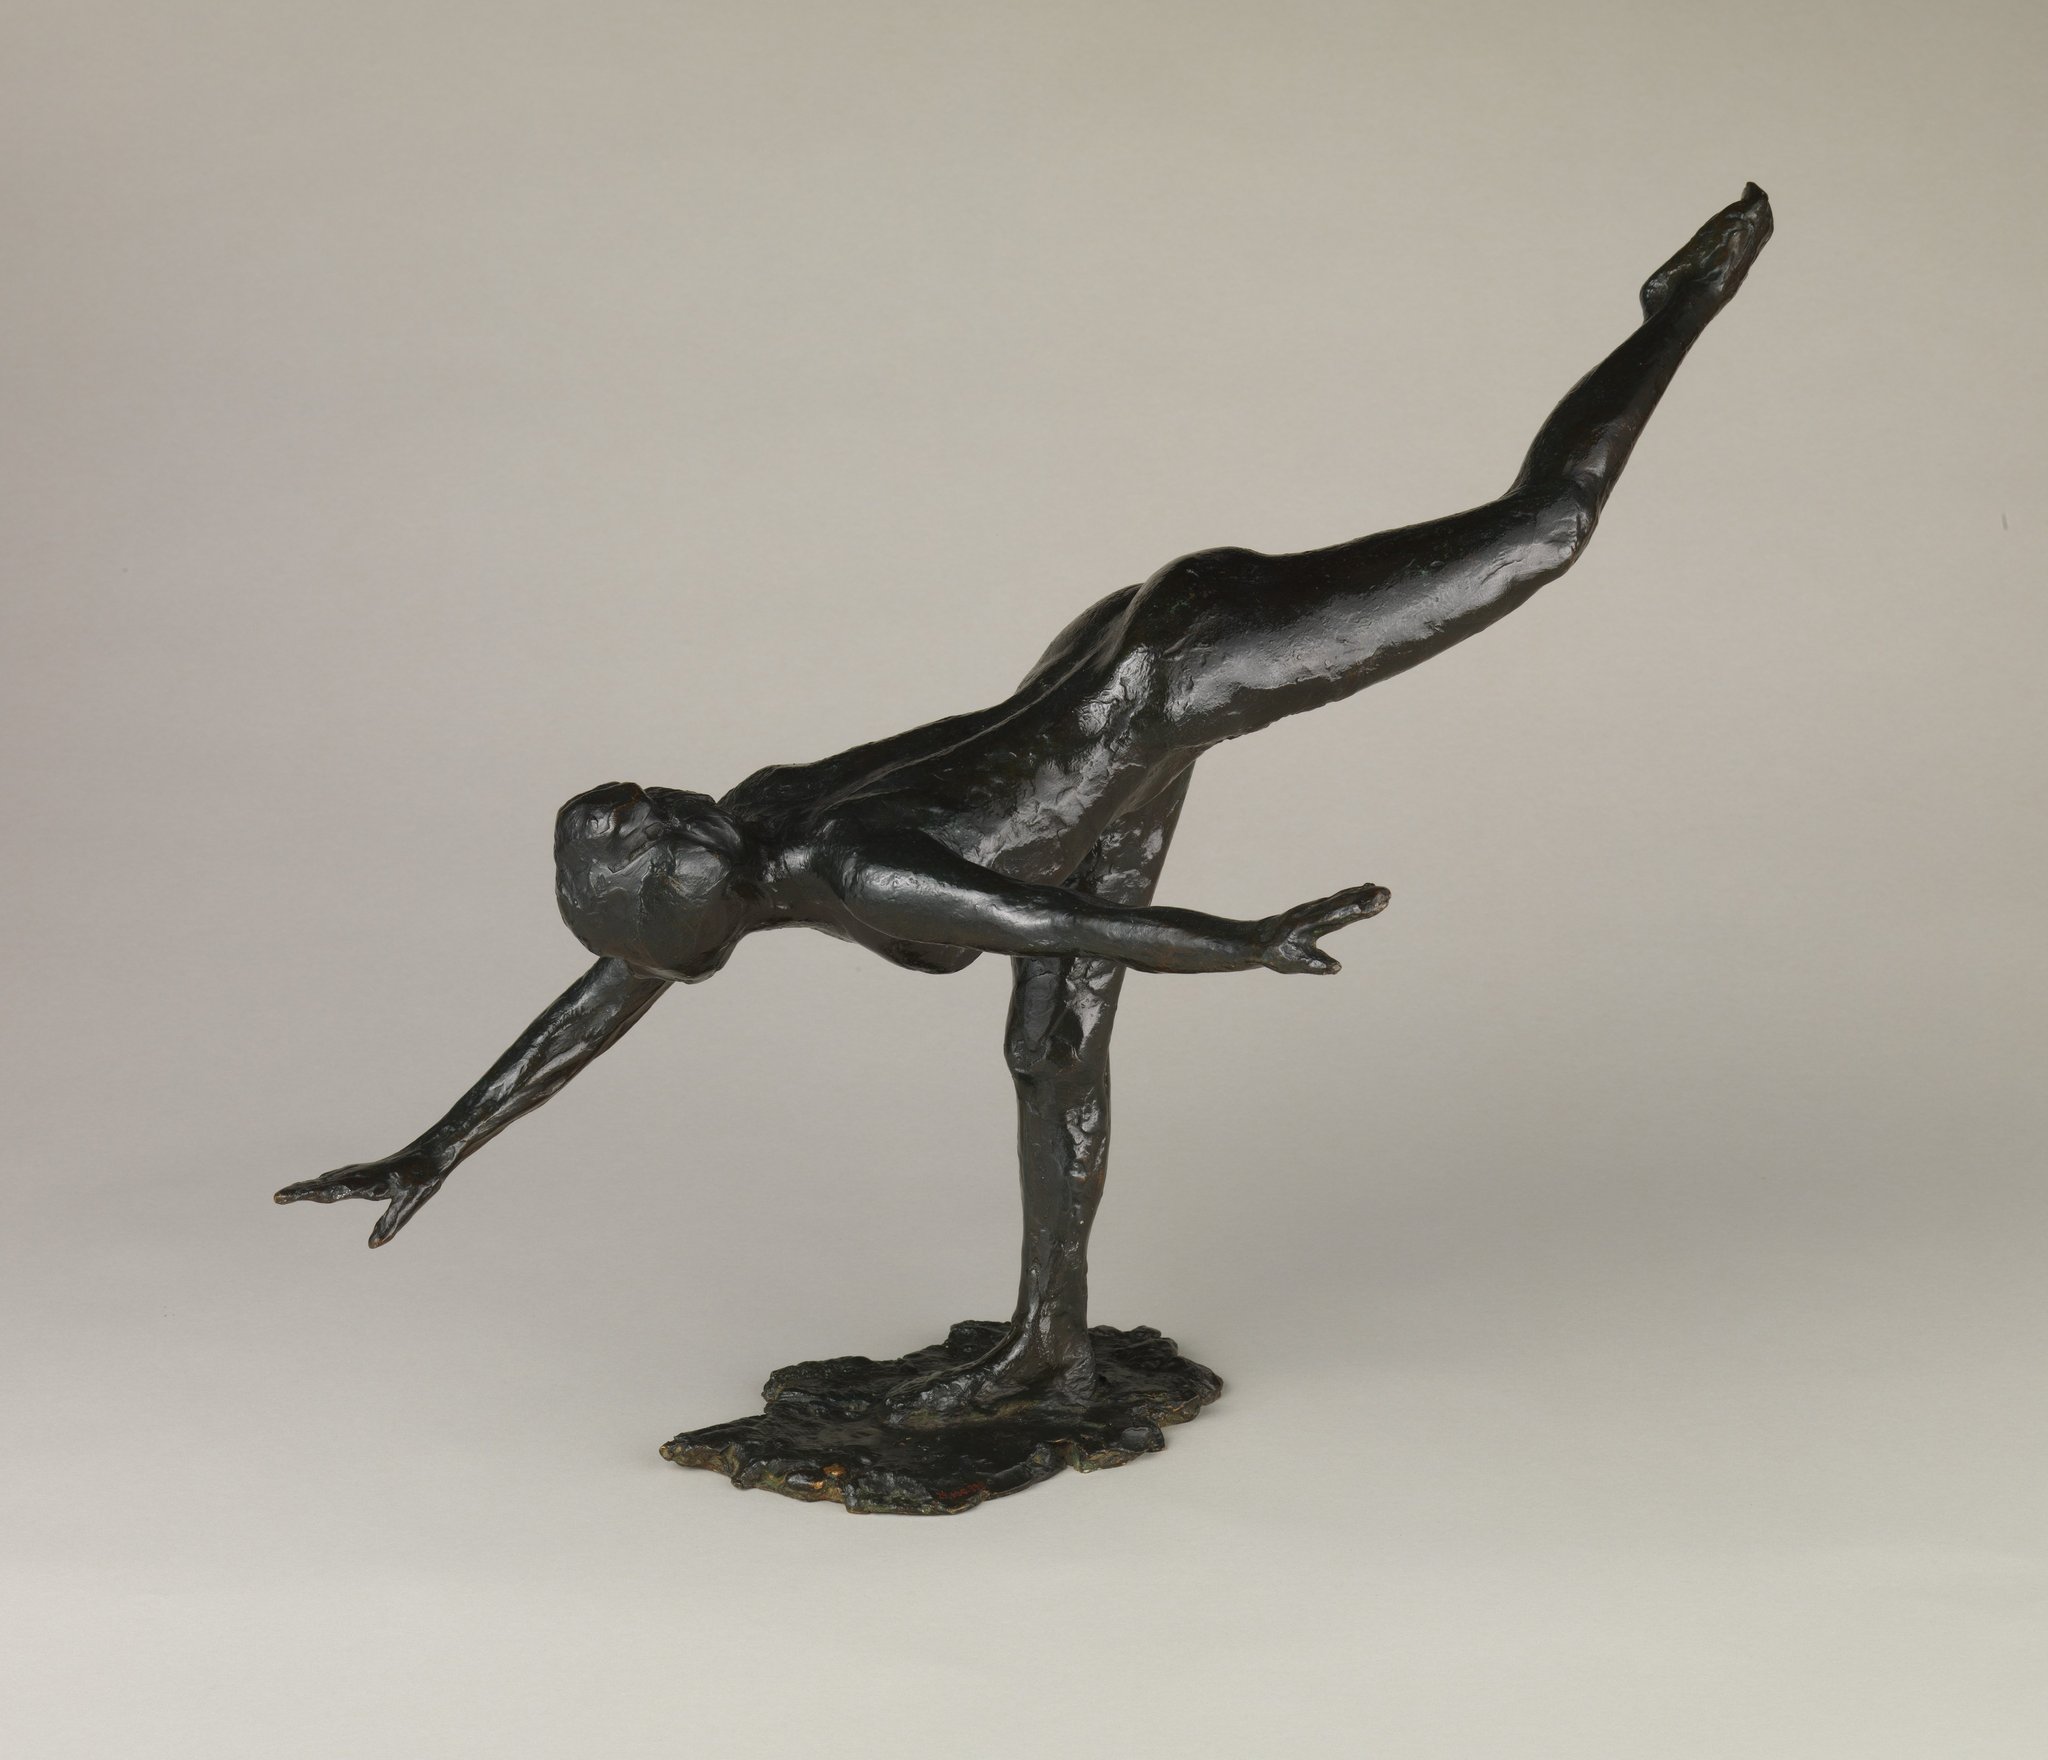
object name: statuette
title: First Arabesque Penchée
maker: edgar degas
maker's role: artist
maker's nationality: french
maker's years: 1834-1917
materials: bronze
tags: female nudes,dancers,ballet